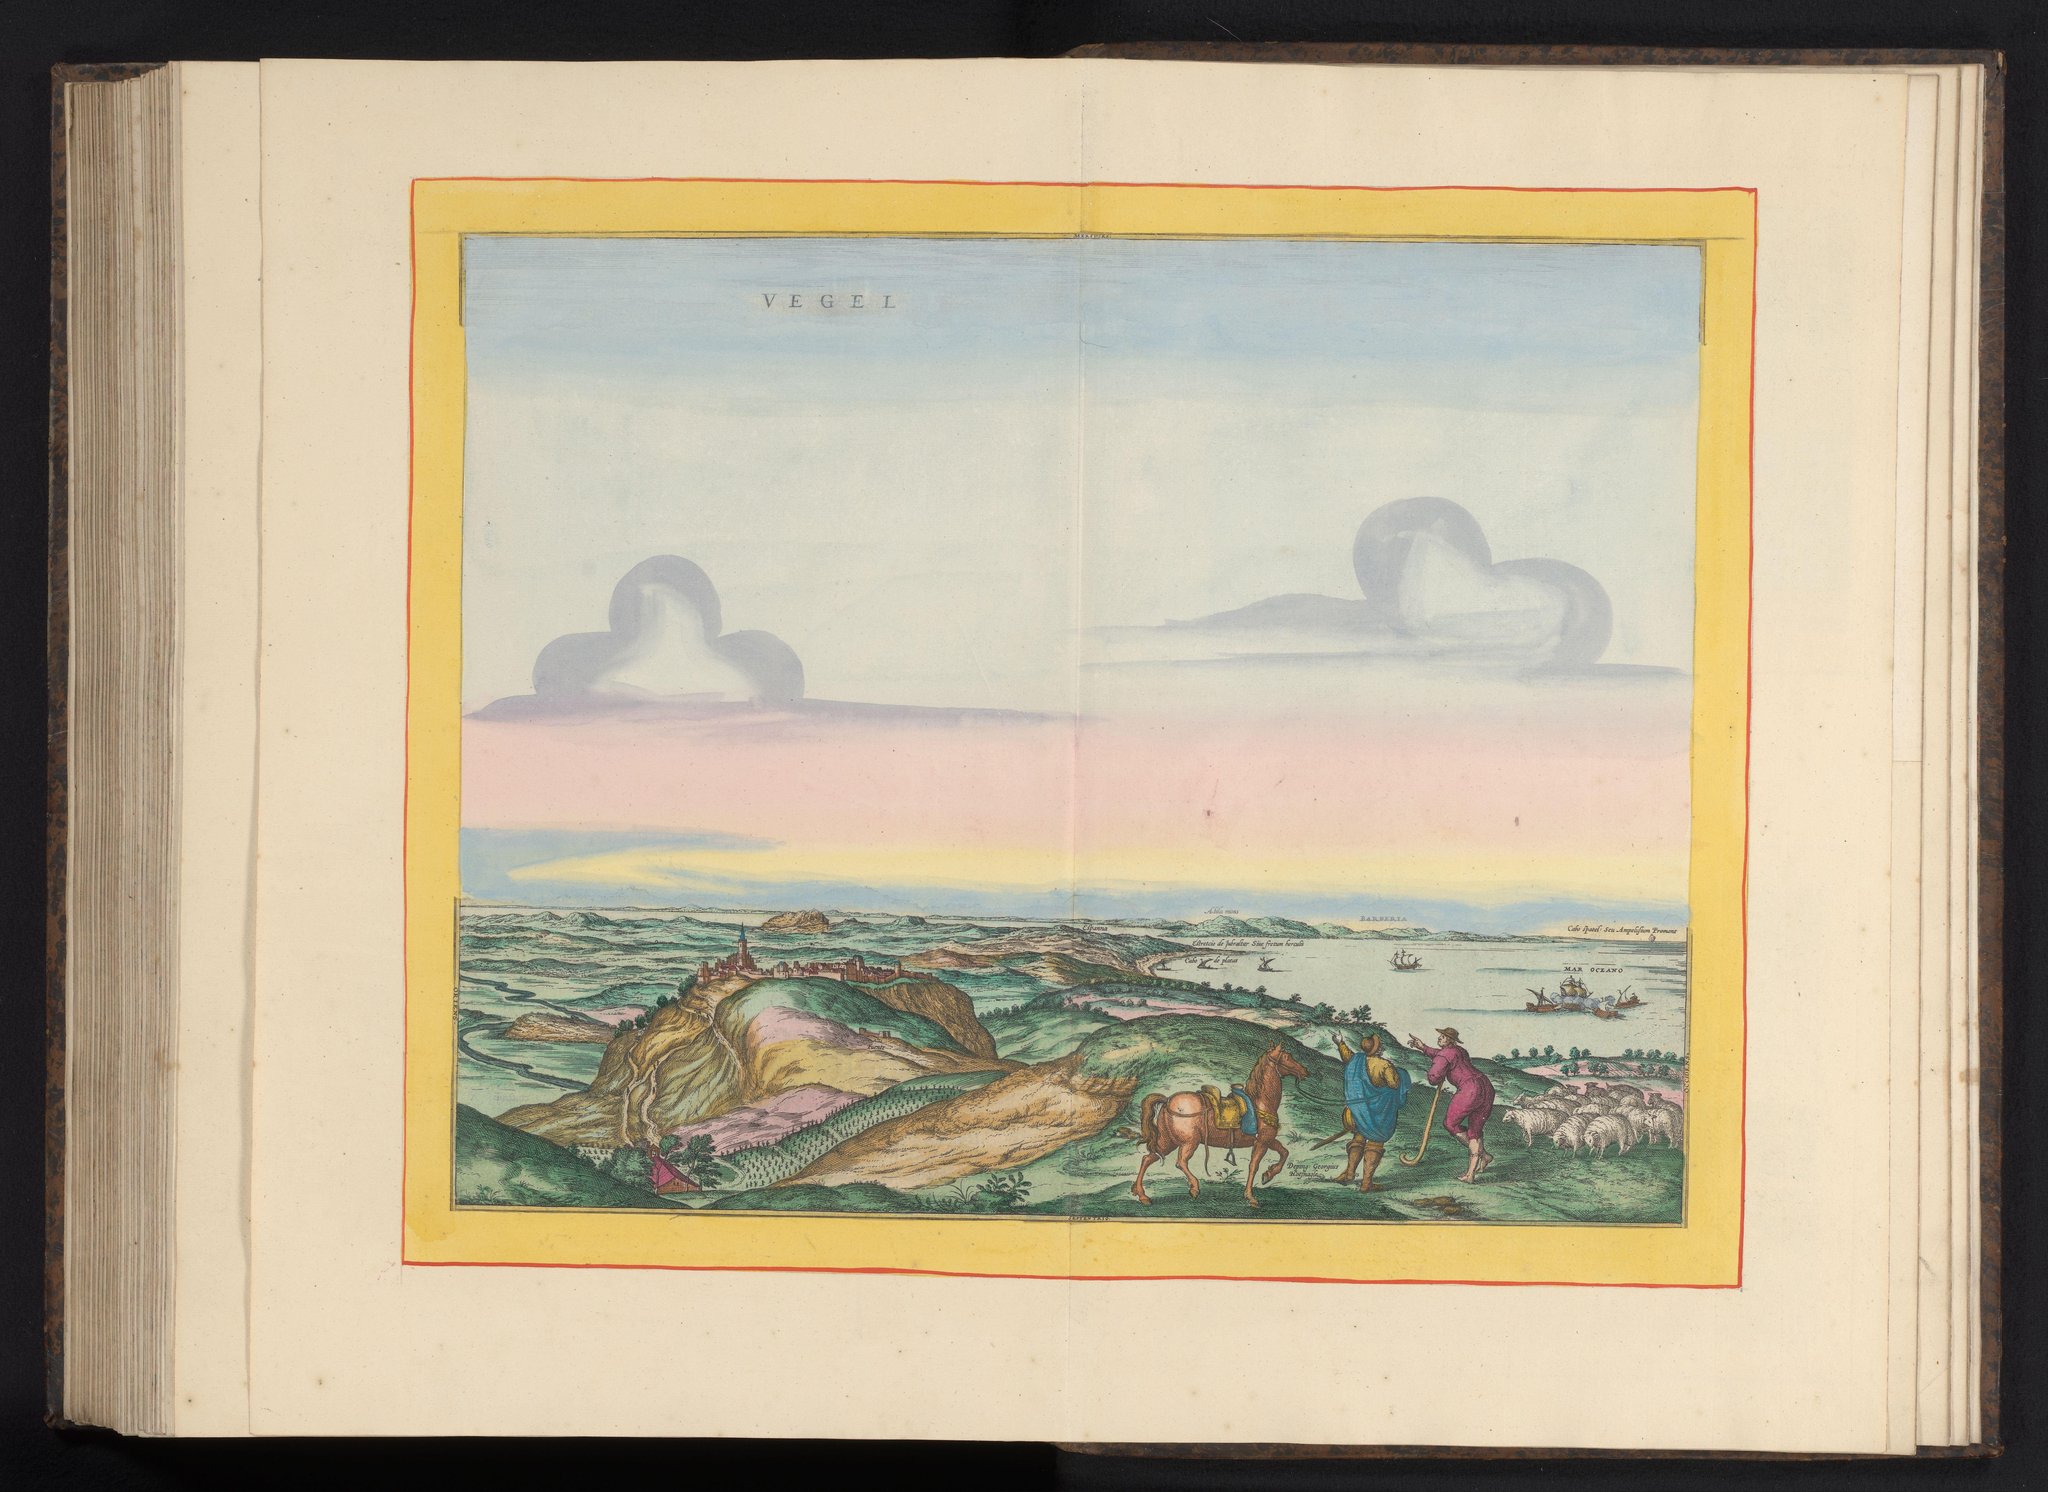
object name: print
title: Vegel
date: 1575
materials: paper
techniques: engraving, etching, hand coloring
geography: the hague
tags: prospect of village, silhouette of village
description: Prent origineel vervaardigd als boekillustratie voor: Georg Braun en Frans Hogenberg. Civitates Orbis Terrarum, 6 delen. Keulen: 1572-1617. De prent werd voor het eerst gepubliceerd in deel 2: De praecipuis totius universi urbibus liber secundus, 1575.